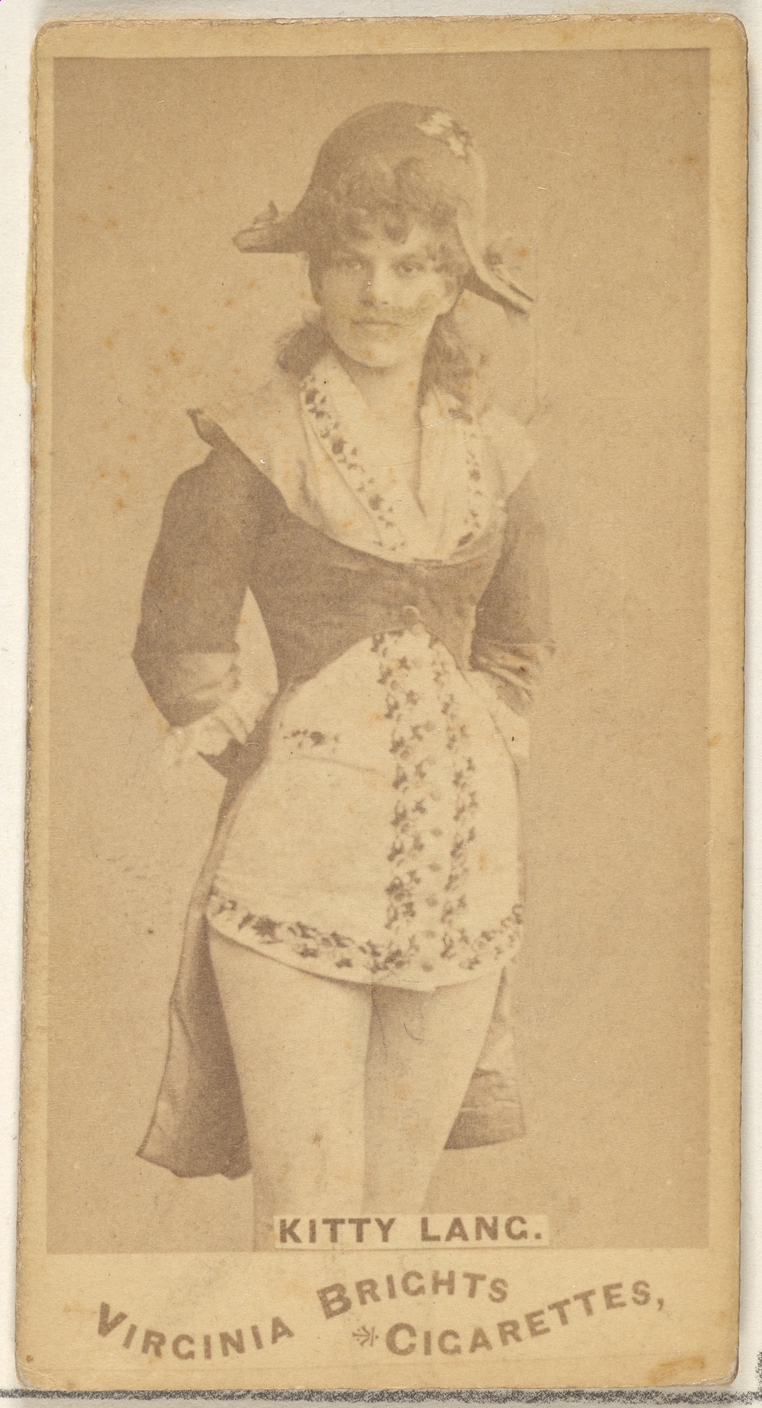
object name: photograph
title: Kitty Lang, from the Actors and Actresses series (N45, Type 1) for Virginia Brights Cigarettes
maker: allen & ginter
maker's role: publisher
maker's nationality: american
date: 1888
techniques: albumen silver print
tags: portraits,women,actresses